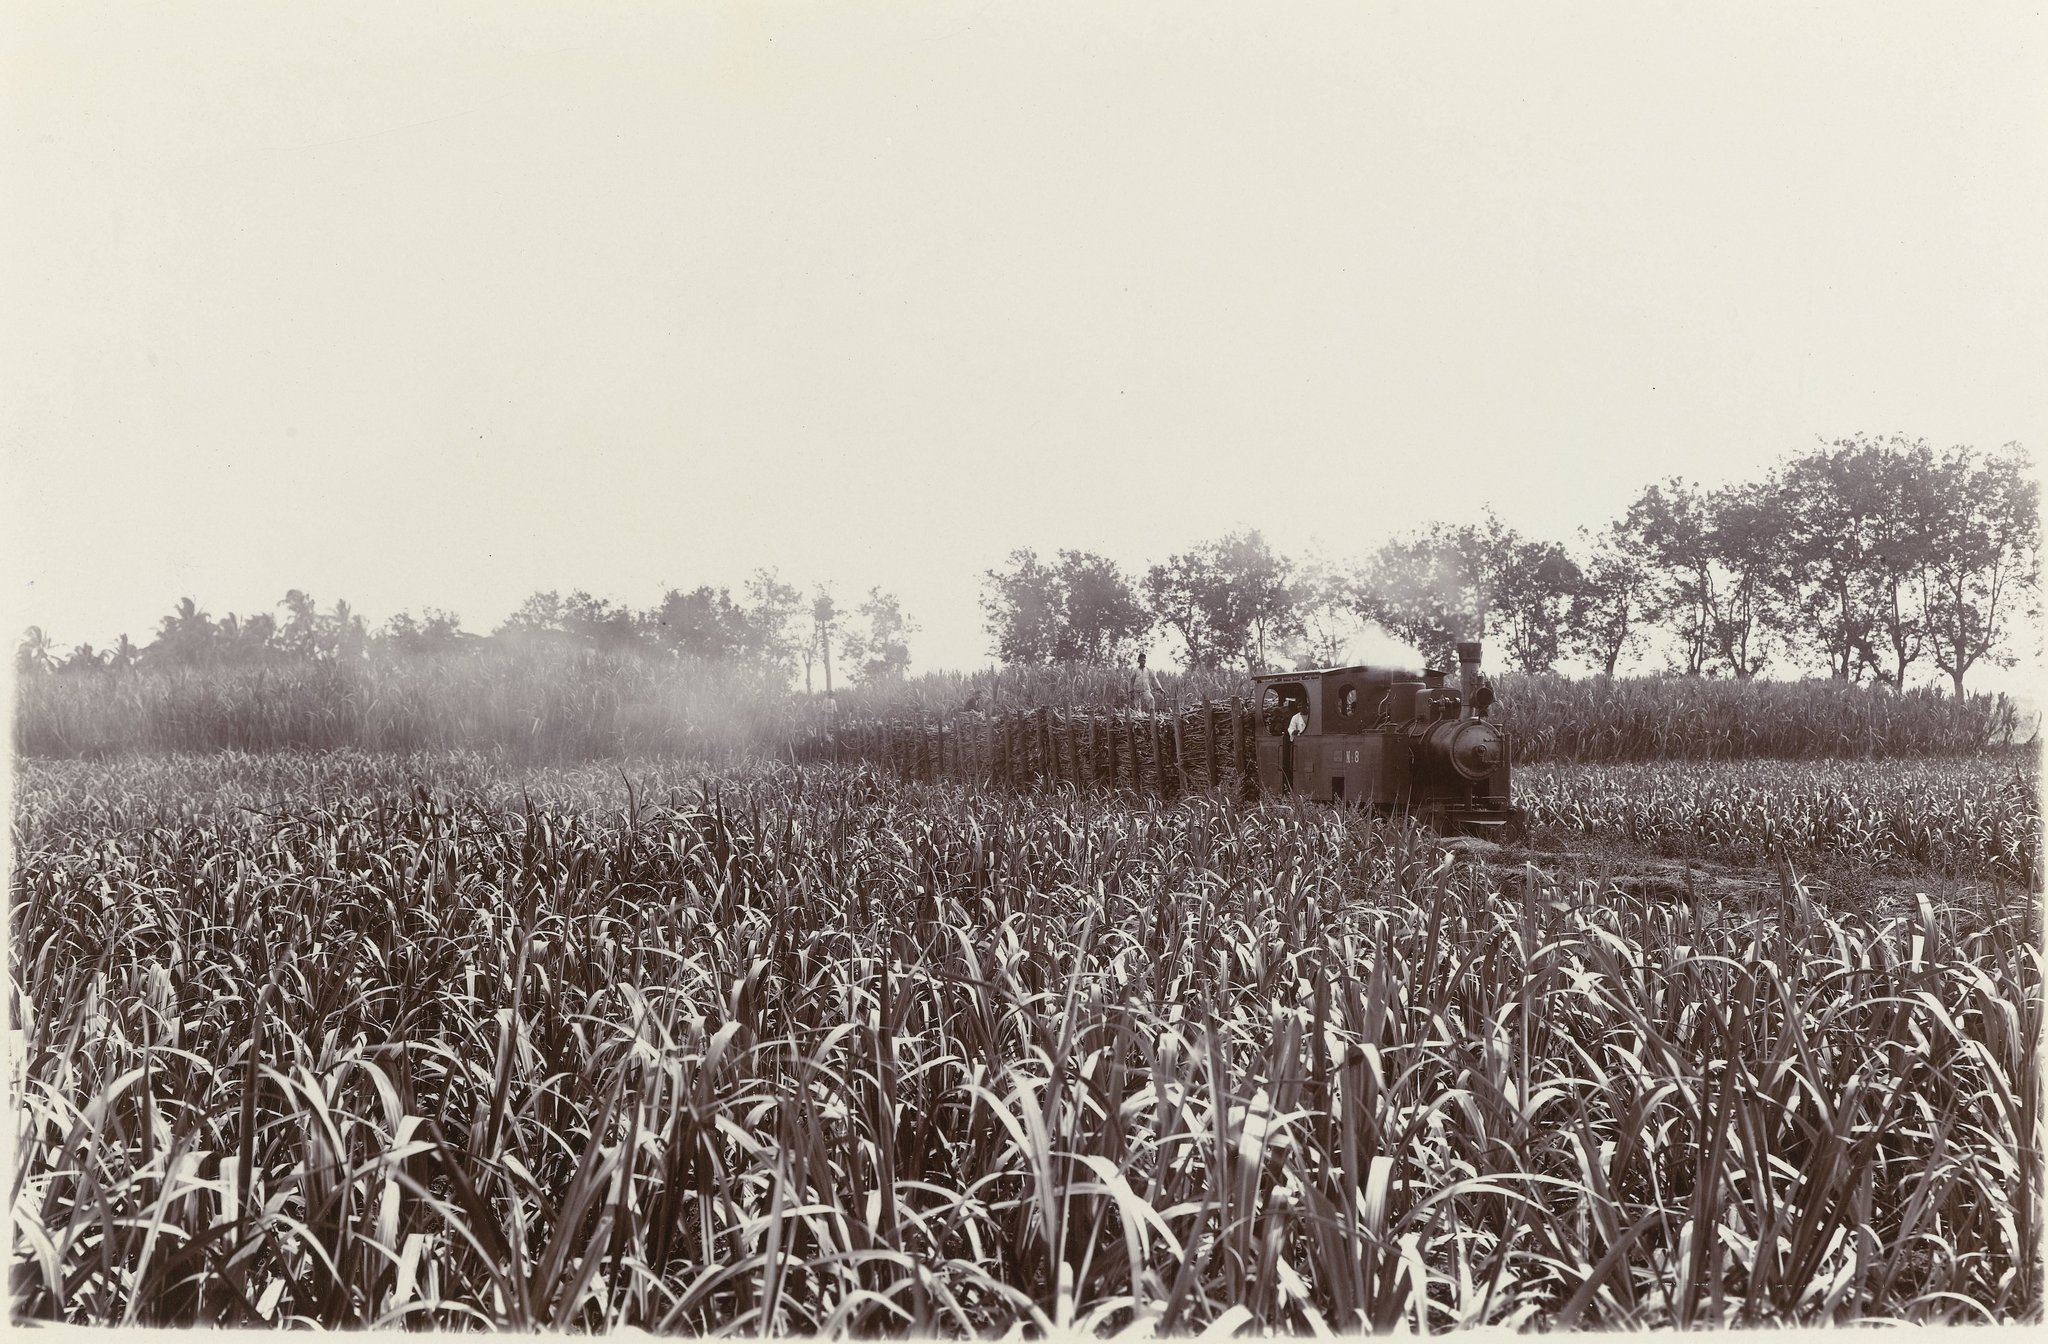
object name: photograph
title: Een suikerlocomotief van de Nederlandsch-Indische Spoorwegen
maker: Anonymous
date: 1900-1919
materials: paper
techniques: photography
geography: indonesia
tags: dutch east indies, the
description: Stoomlocomotief nr. 8 met een aantal met suikerriet beladen wagens rijdend door de suikerrietvelden.